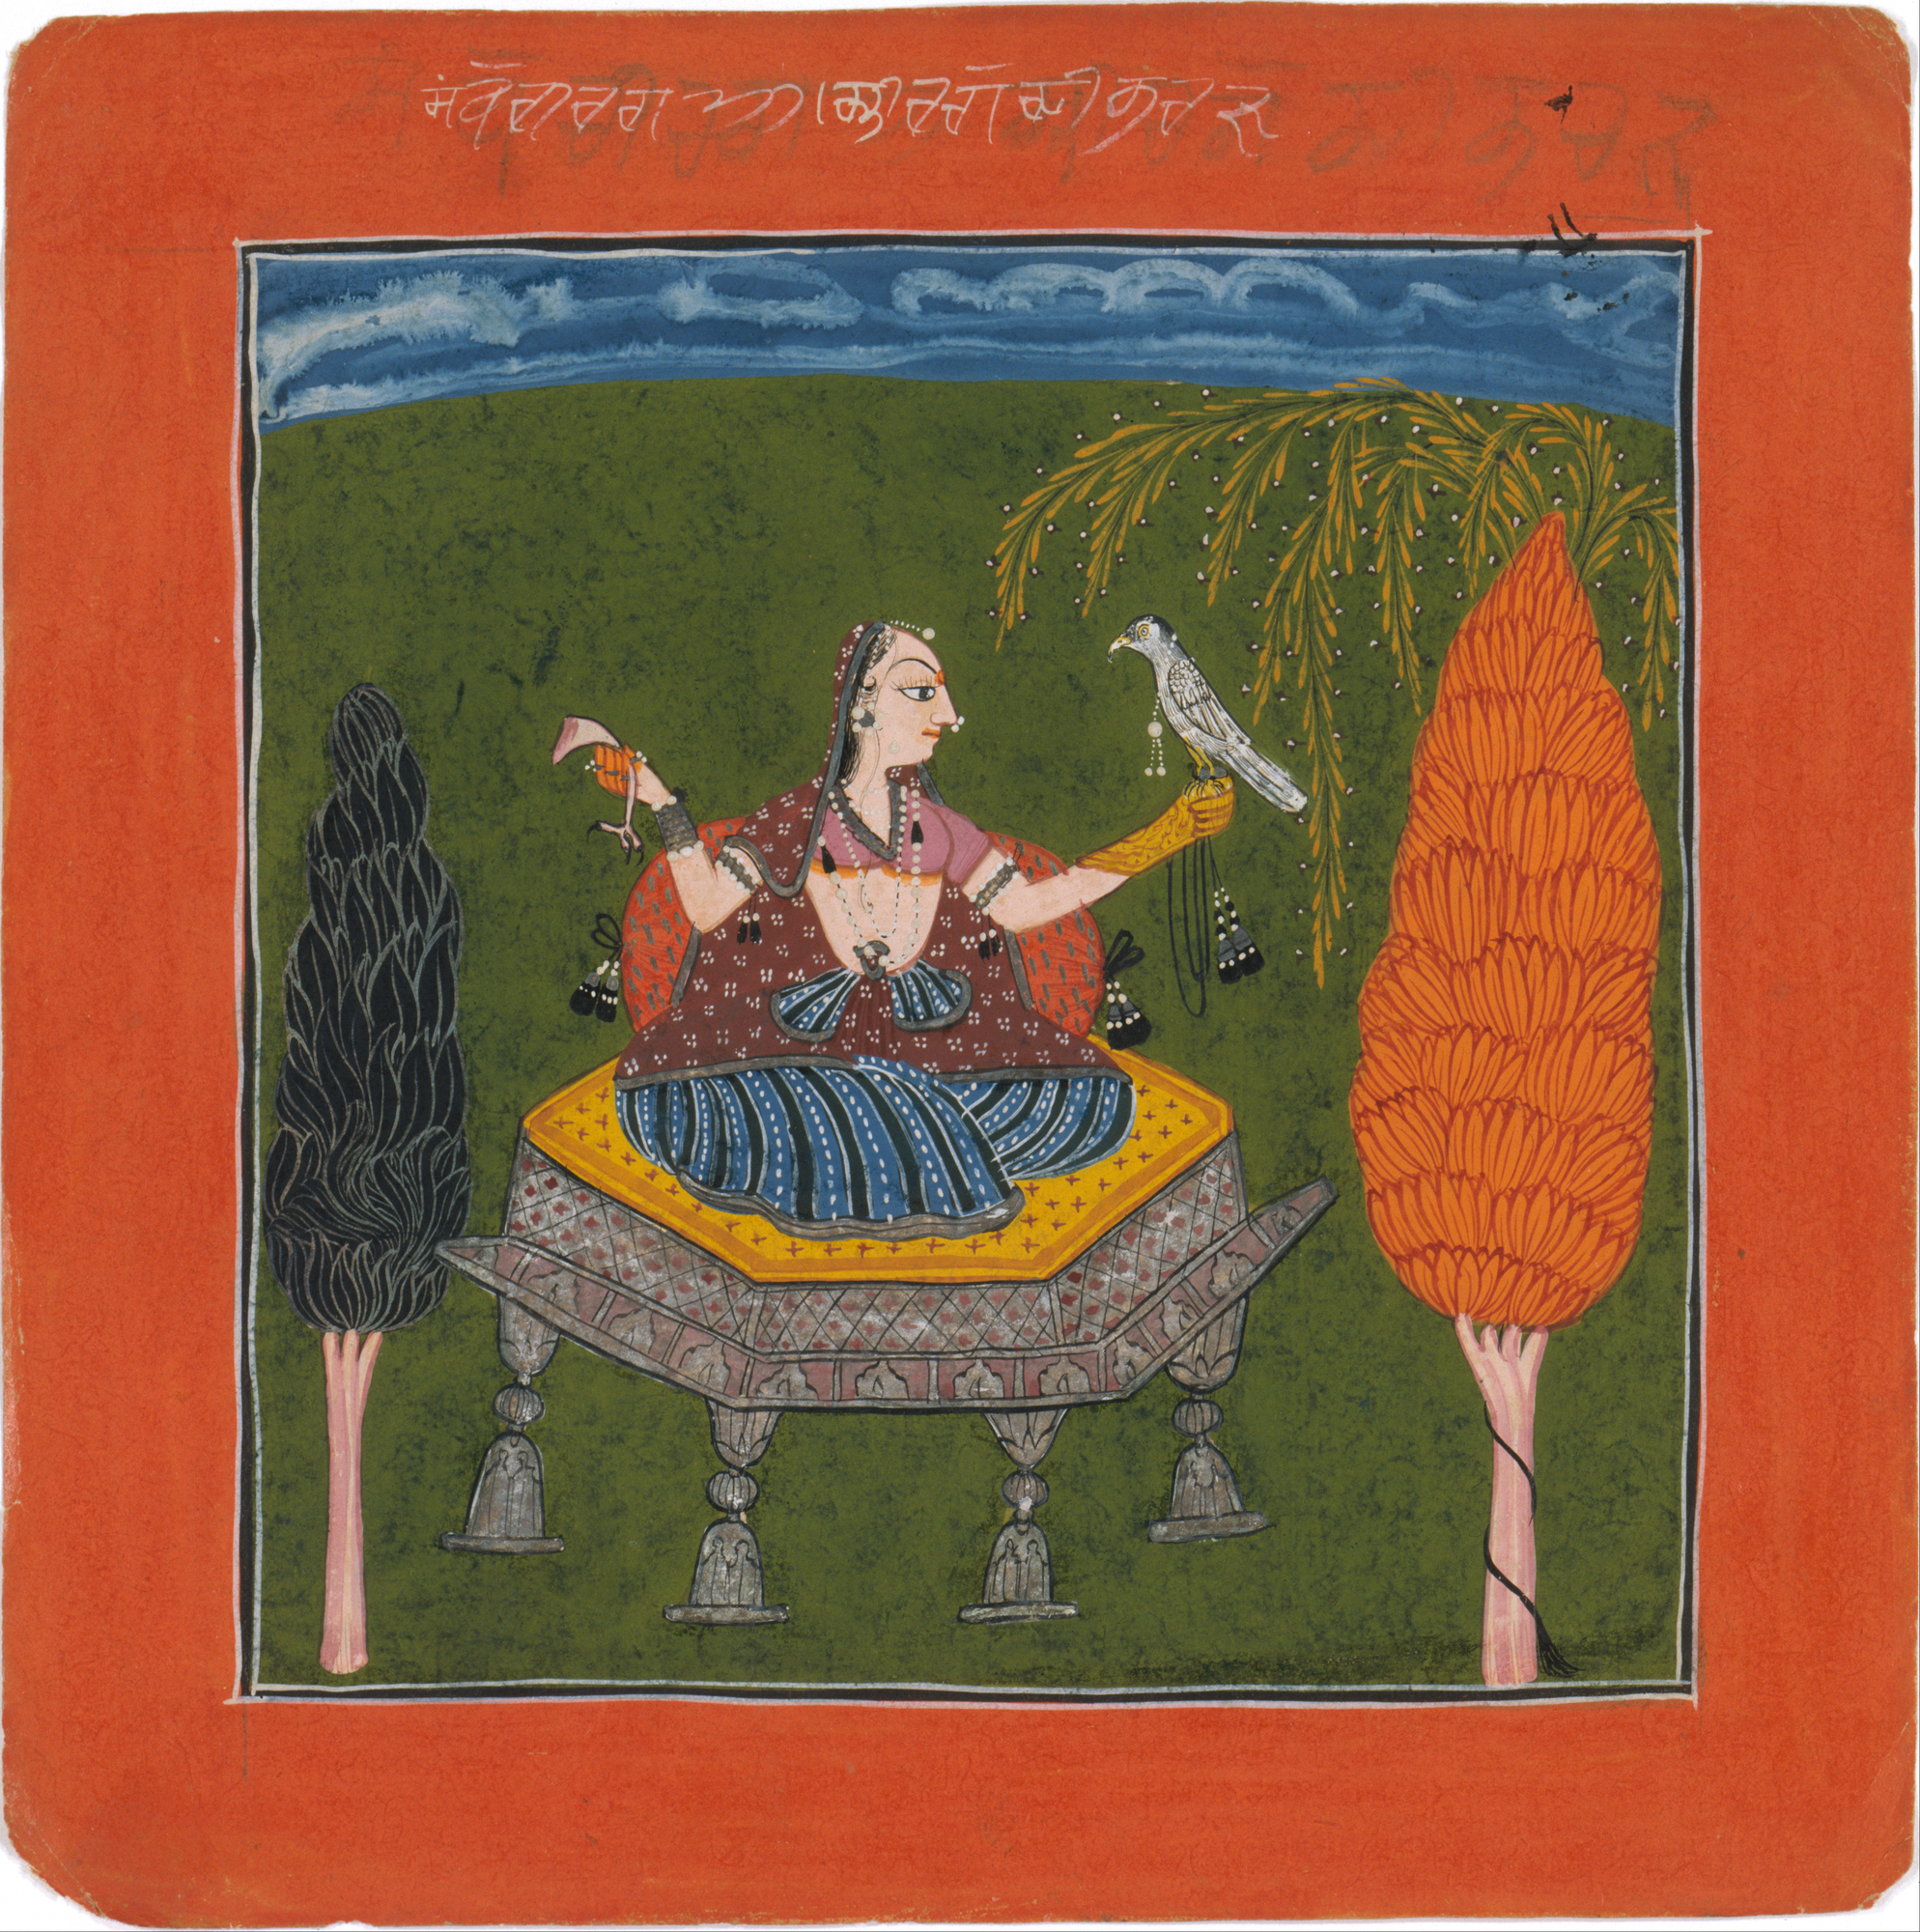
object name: page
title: Sanveri Ragini, Page from a Ragamala Series (Garland of Musical Modes)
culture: indian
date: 1700-1710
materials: ink, paper, silver, watercolor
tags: falcons,women